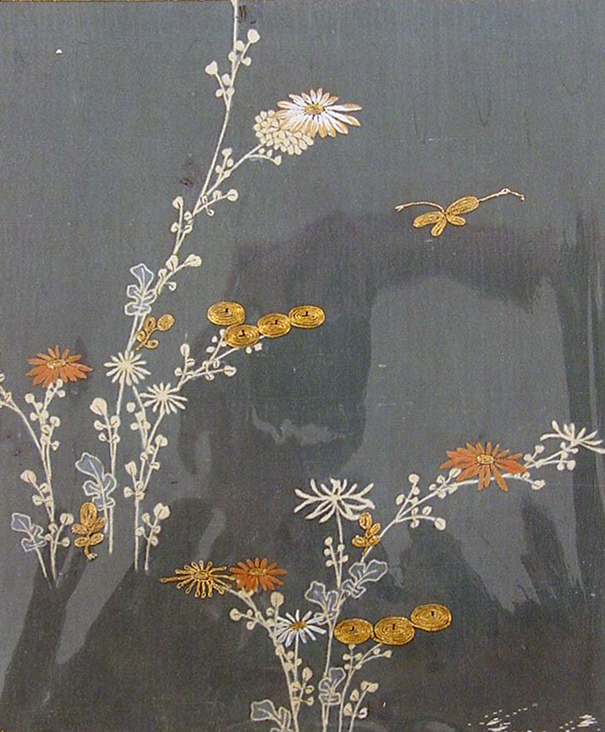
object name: piece from a kosode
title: Piece from a Kosode with Chrysanthemums and Butterfly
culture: japanese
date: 1615-1868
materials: metal thread, silk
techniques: dyeing, embroidery, weave, resist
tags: butterflies,flowers